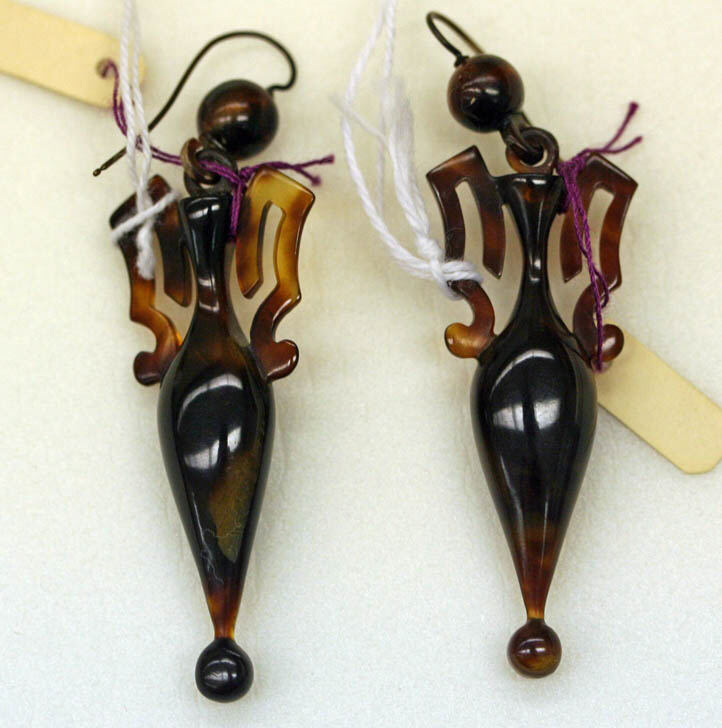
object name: pierced earring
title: Pierced earrings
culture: american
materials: gold, shell